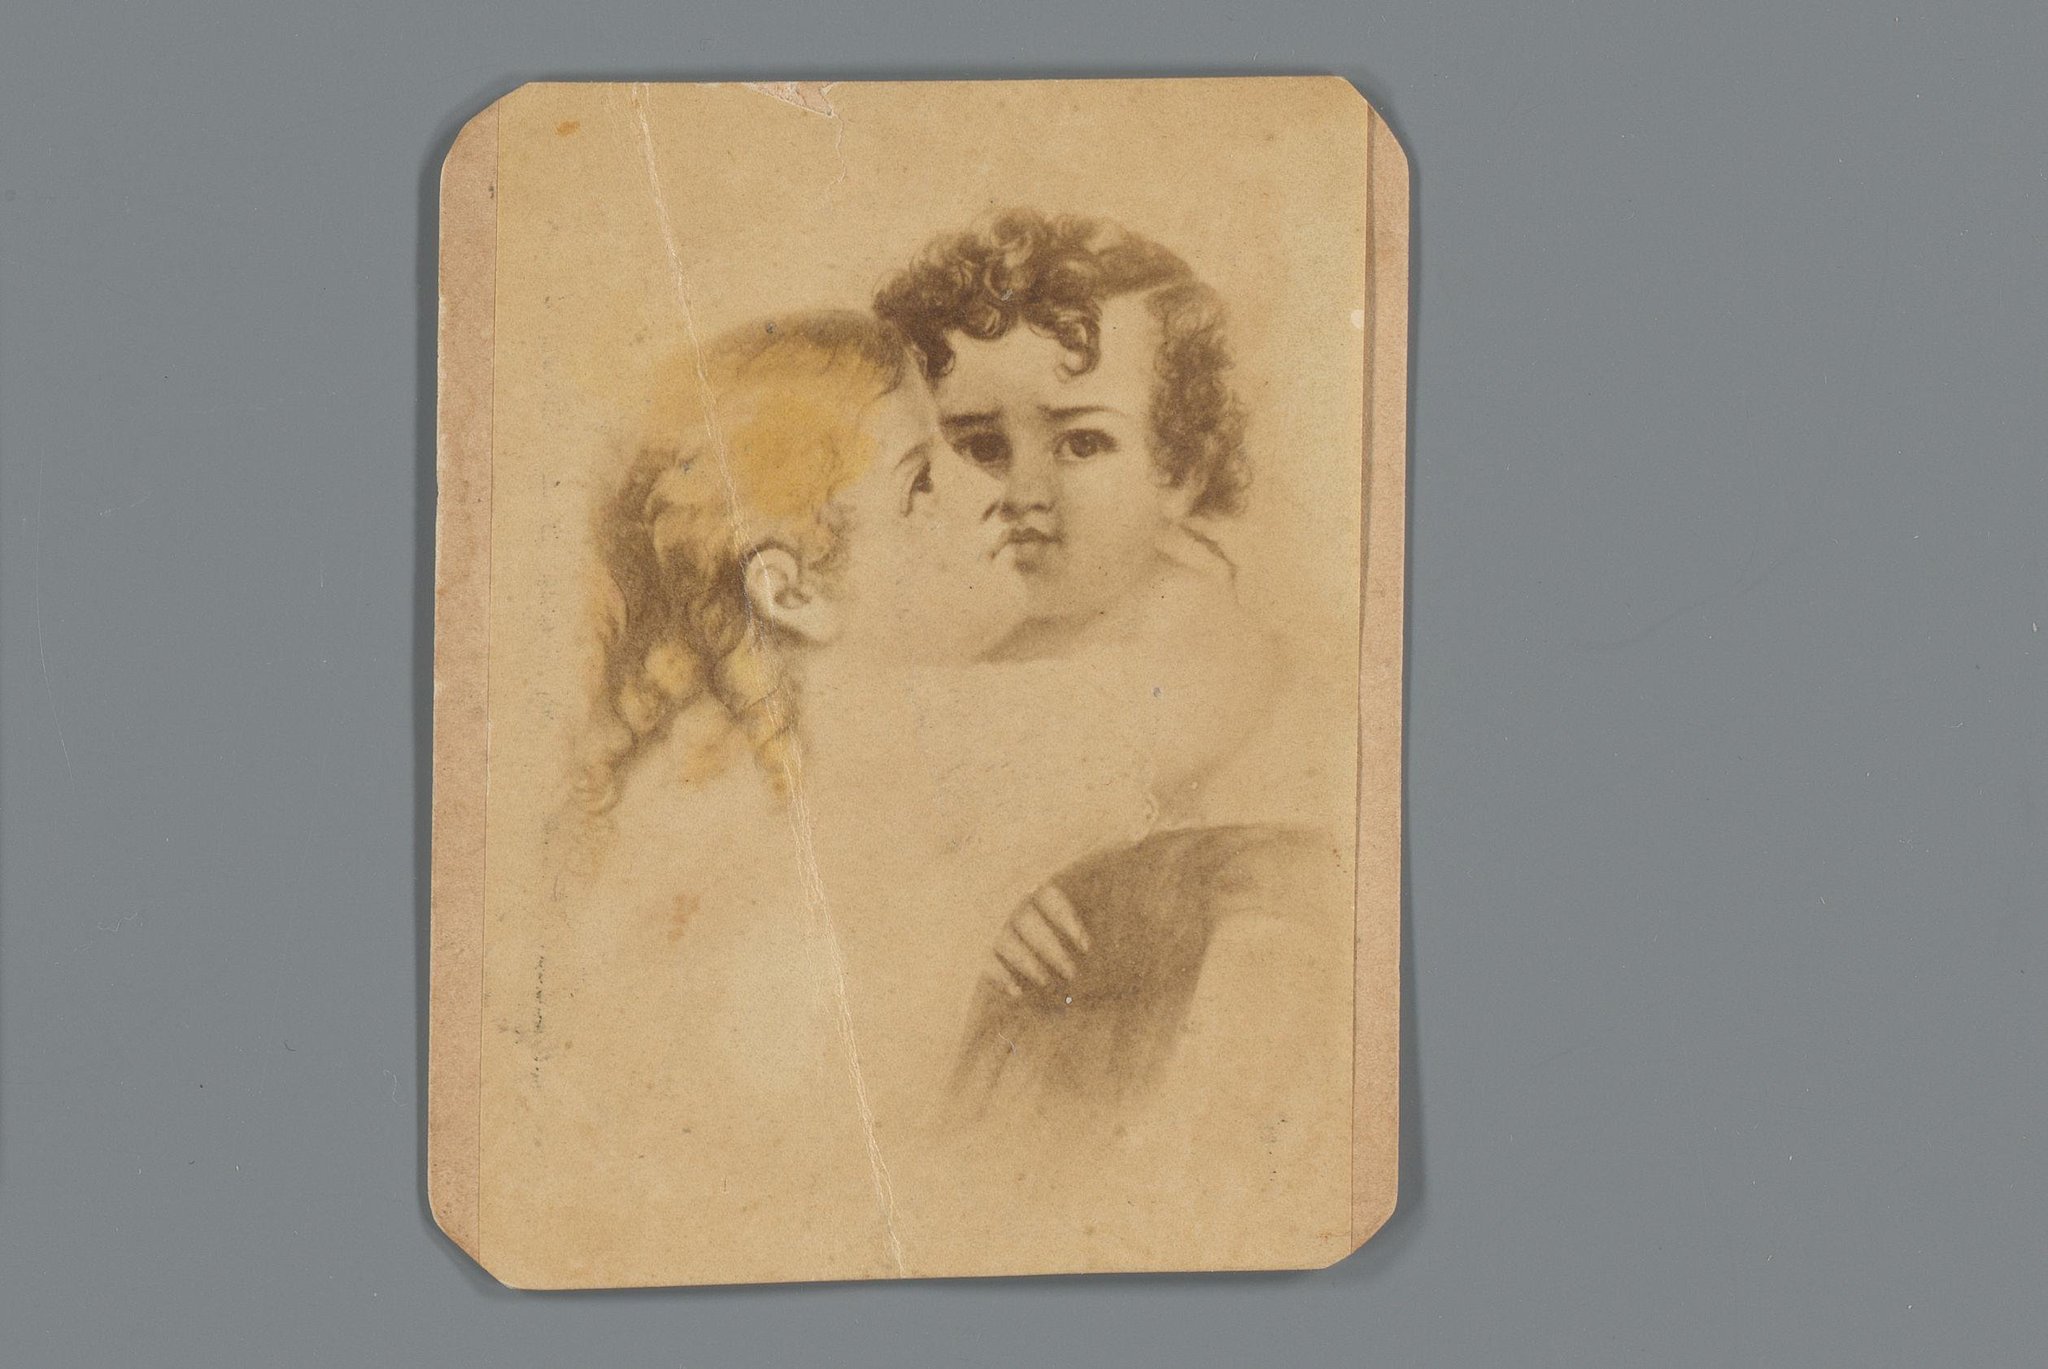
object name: photograph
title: Fotoreproductie van een tekening van een jongen en een meisje als reclame voor kledingzaak Pierson & Hews in New Orleans, Louisiana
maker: Anonymous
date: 1850-1915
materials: cardboard, photographic support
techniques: albumen print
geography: new orleans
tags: advertising, child, embracing each other, kissing, textile industry and clothing industry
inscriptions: inscription: ‘PIERSON & HEWS, Successors to PITKIN, PIERSON & CO/ DEALERS IN/ FINE CLOTHING/ AND/ FURNISHING GOODS/ No.s 13 and 15 Camp Street,/ Wm. H. Pierson,/ E.L. Hews/ New Orleans’